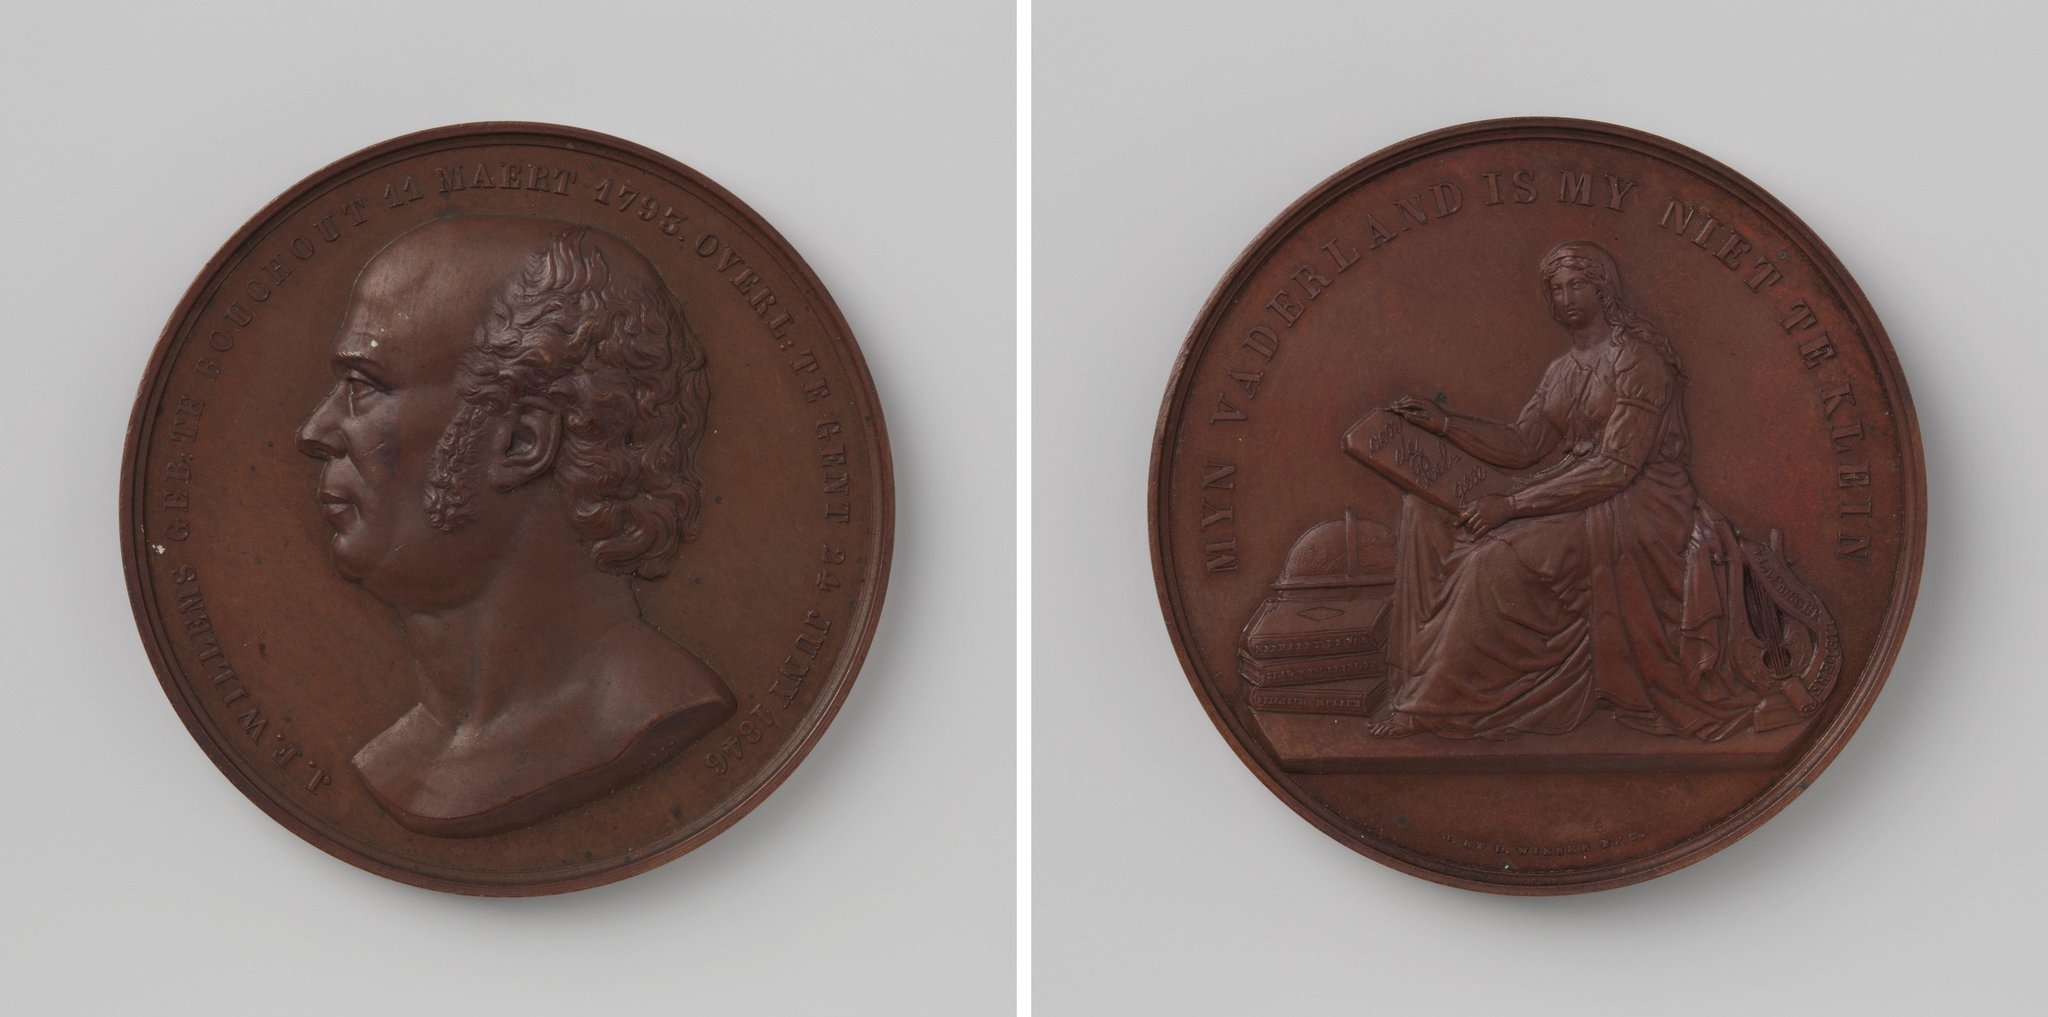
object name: history medal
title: Overlijden van J.F. Willems, dichter uit Vlaanderen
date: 1847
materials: bronze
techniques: striking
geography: brussels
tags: ghent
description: Bronzen penning. Voorzijde: borststuk man binnen omschrift. Keerzijde: vrouw met beschreven tafel op inbeide handen, zit tussen stapel boeken, globe en lier, omhangen met wimpel met opschriftbinnen omschrift; afsnede: signatuur